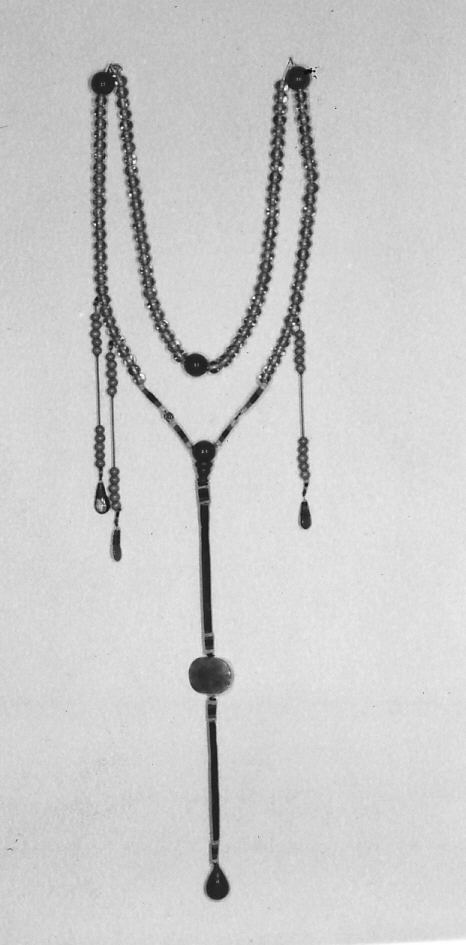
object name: rosary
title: Court necklace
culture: chinese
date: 1801-1900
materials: glass, metal, silk